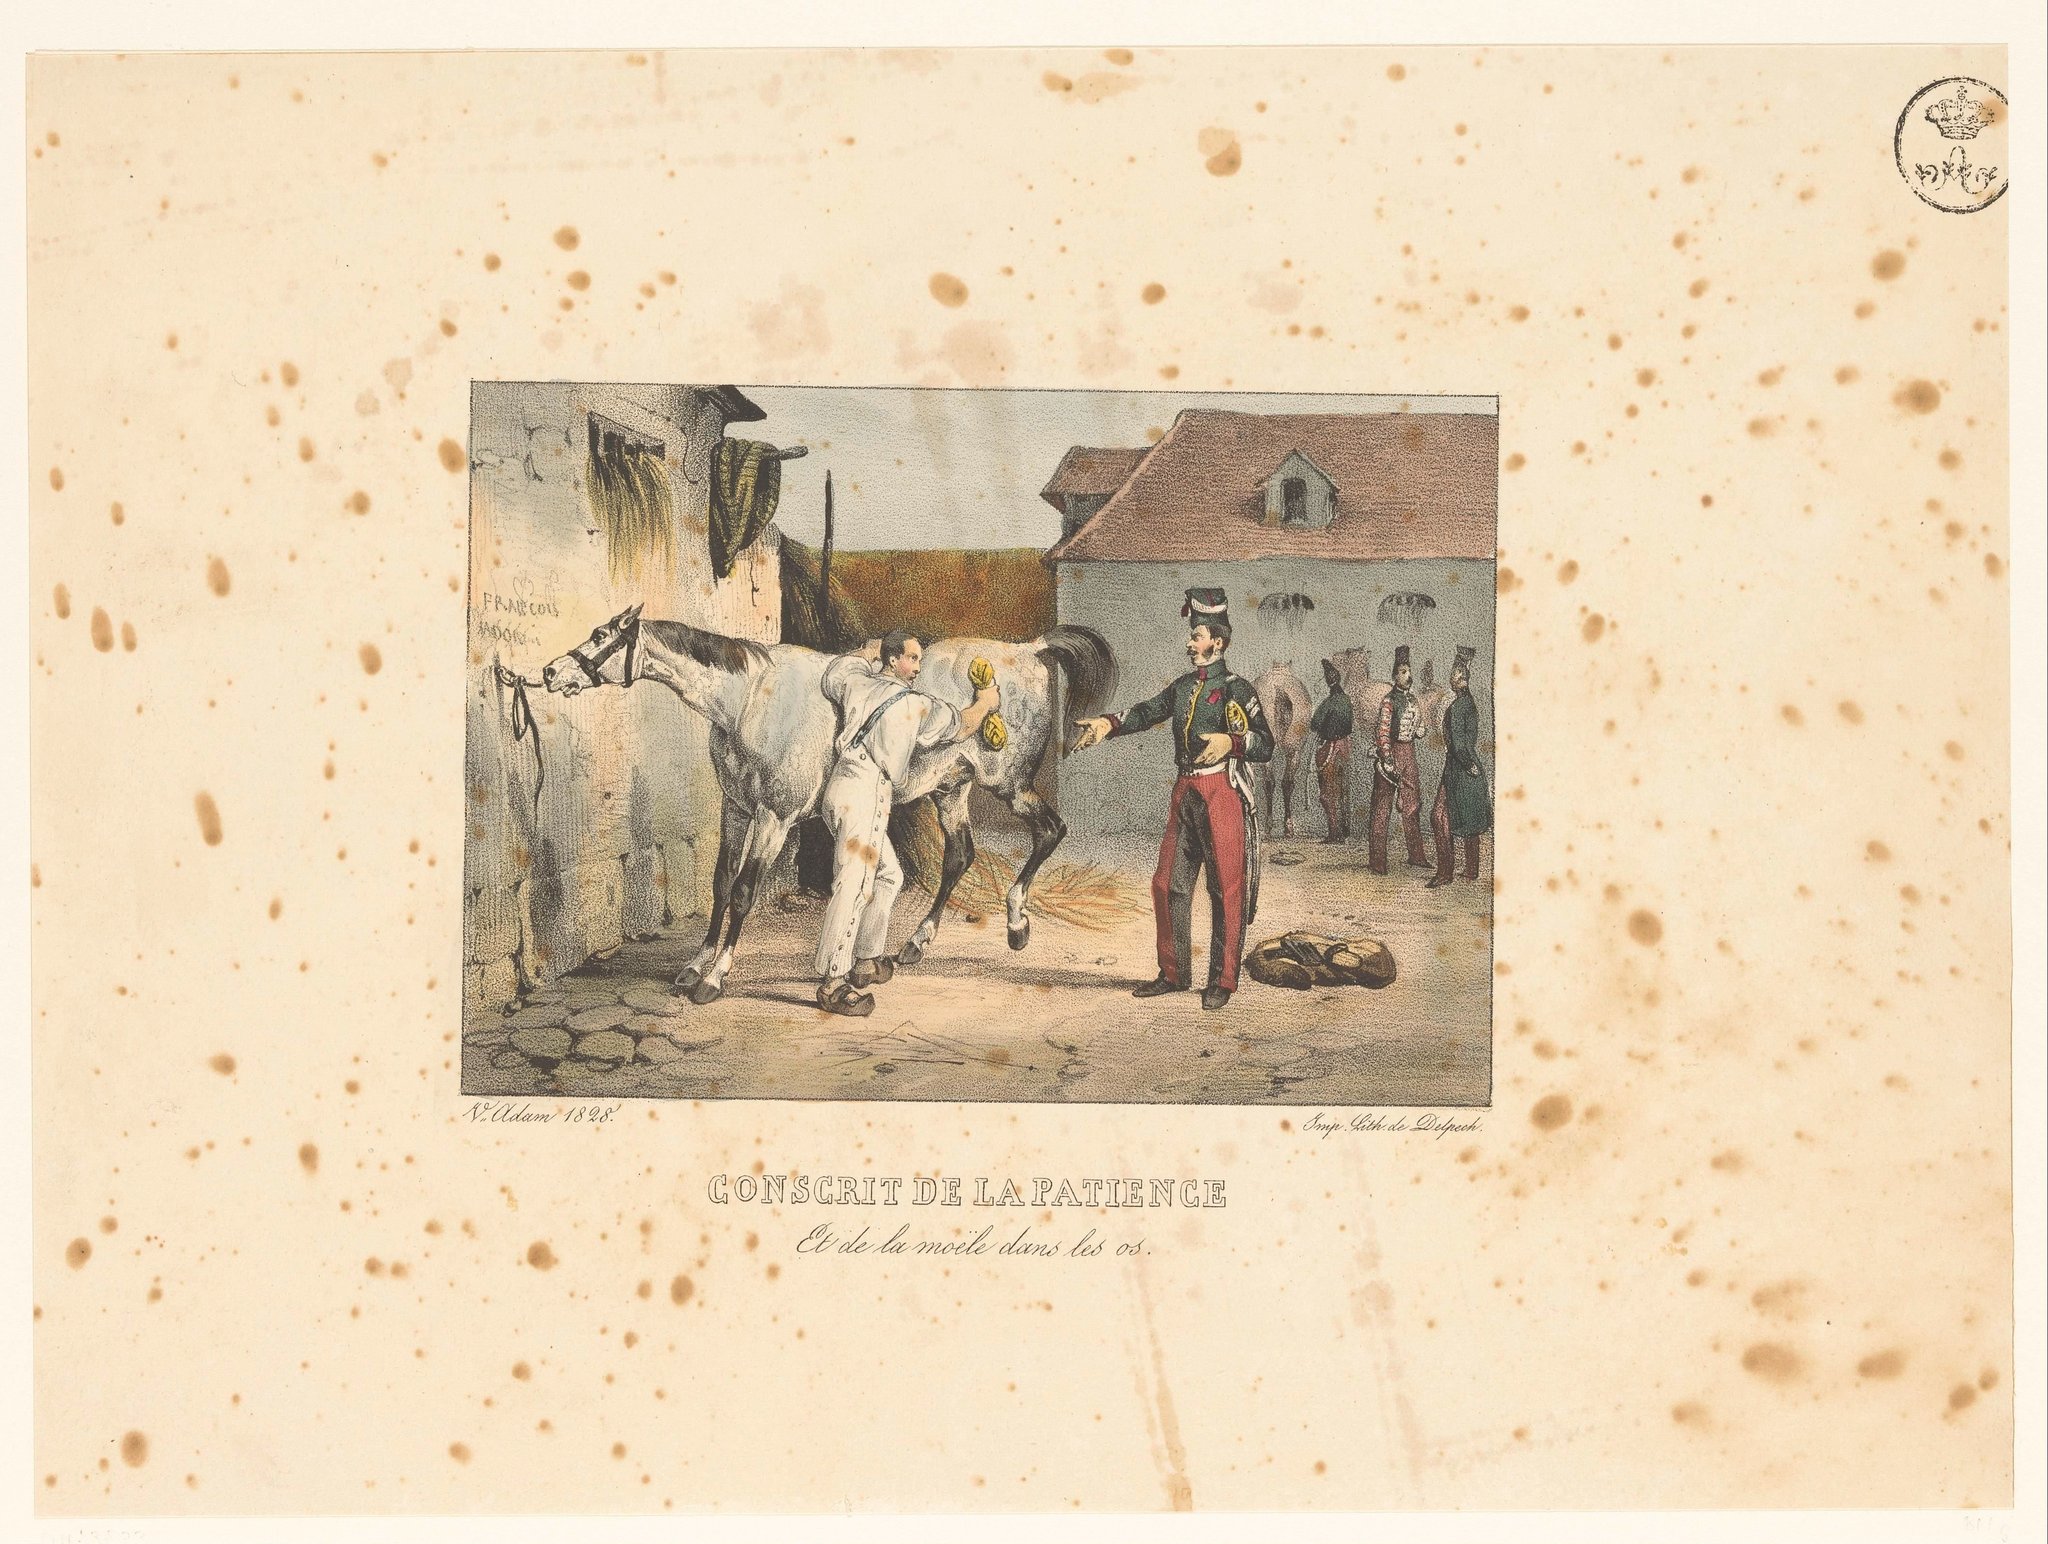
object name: print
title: Scènes militaires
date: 1828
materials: paper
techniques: hand coloring, lithograph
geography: paris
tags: the soldier; the soldier's life, horse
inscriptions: collector's mark: Lugt 2228, stamp: ‘A’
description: Een rekruut poetst een paard, terwijl hij orders krijgt van een officier.